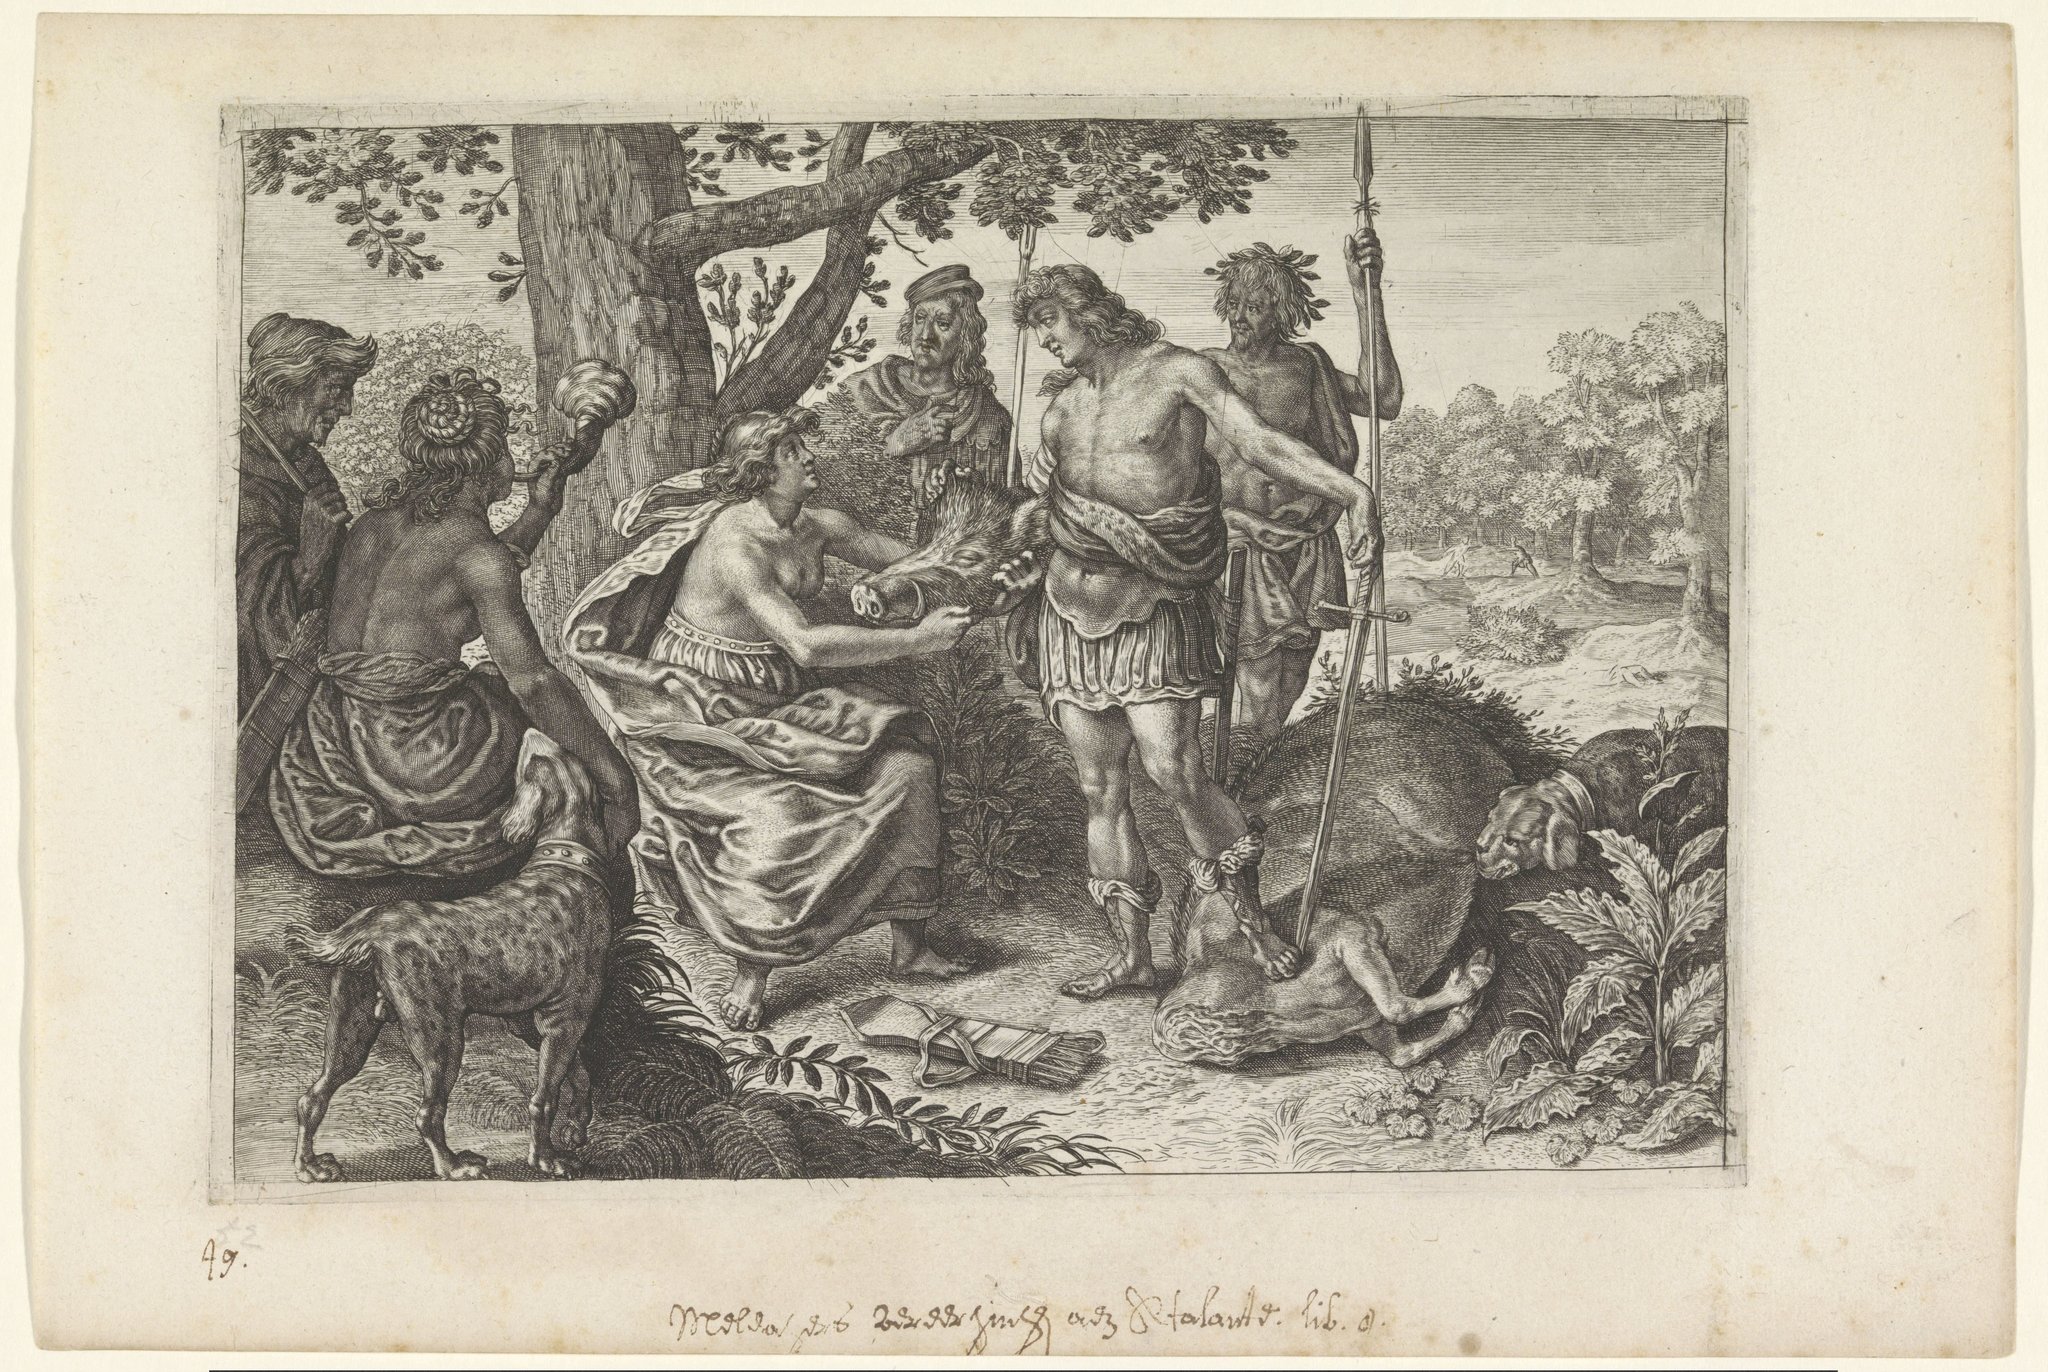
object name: print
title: Meleager geeft de kop van het Caledonische zwijn aan Atalanta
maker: crispijn van de passe (ii)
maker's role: draughtsman, print maker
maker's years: 1594-1670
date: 1636-1670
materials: paper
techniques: engraving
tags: meleager gives the head of the boar to atalanta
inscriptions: collector's mark: ‘Hinloopen’, annotation: ‘Meleagers vereeringh aen Atalanta. lib. 8.’, number: ‘49’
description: Deze incomplete serie, bestaande uit 77 van de in totaal 85 prenten met scènes uit Ovidius' Metamorfosen, werd in 1709 samen met Ovidius-illustraties van Tempesta, Goltzius en Le Pautre in één album, Schijnvoet nummer 43, ingebonden. In de negentiende eeuw werd deze band weer uit elkaar gehaald.